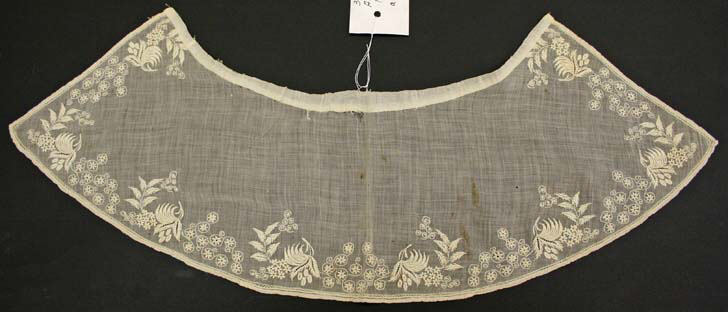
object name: collar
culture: french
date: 1801-1900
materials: cotton